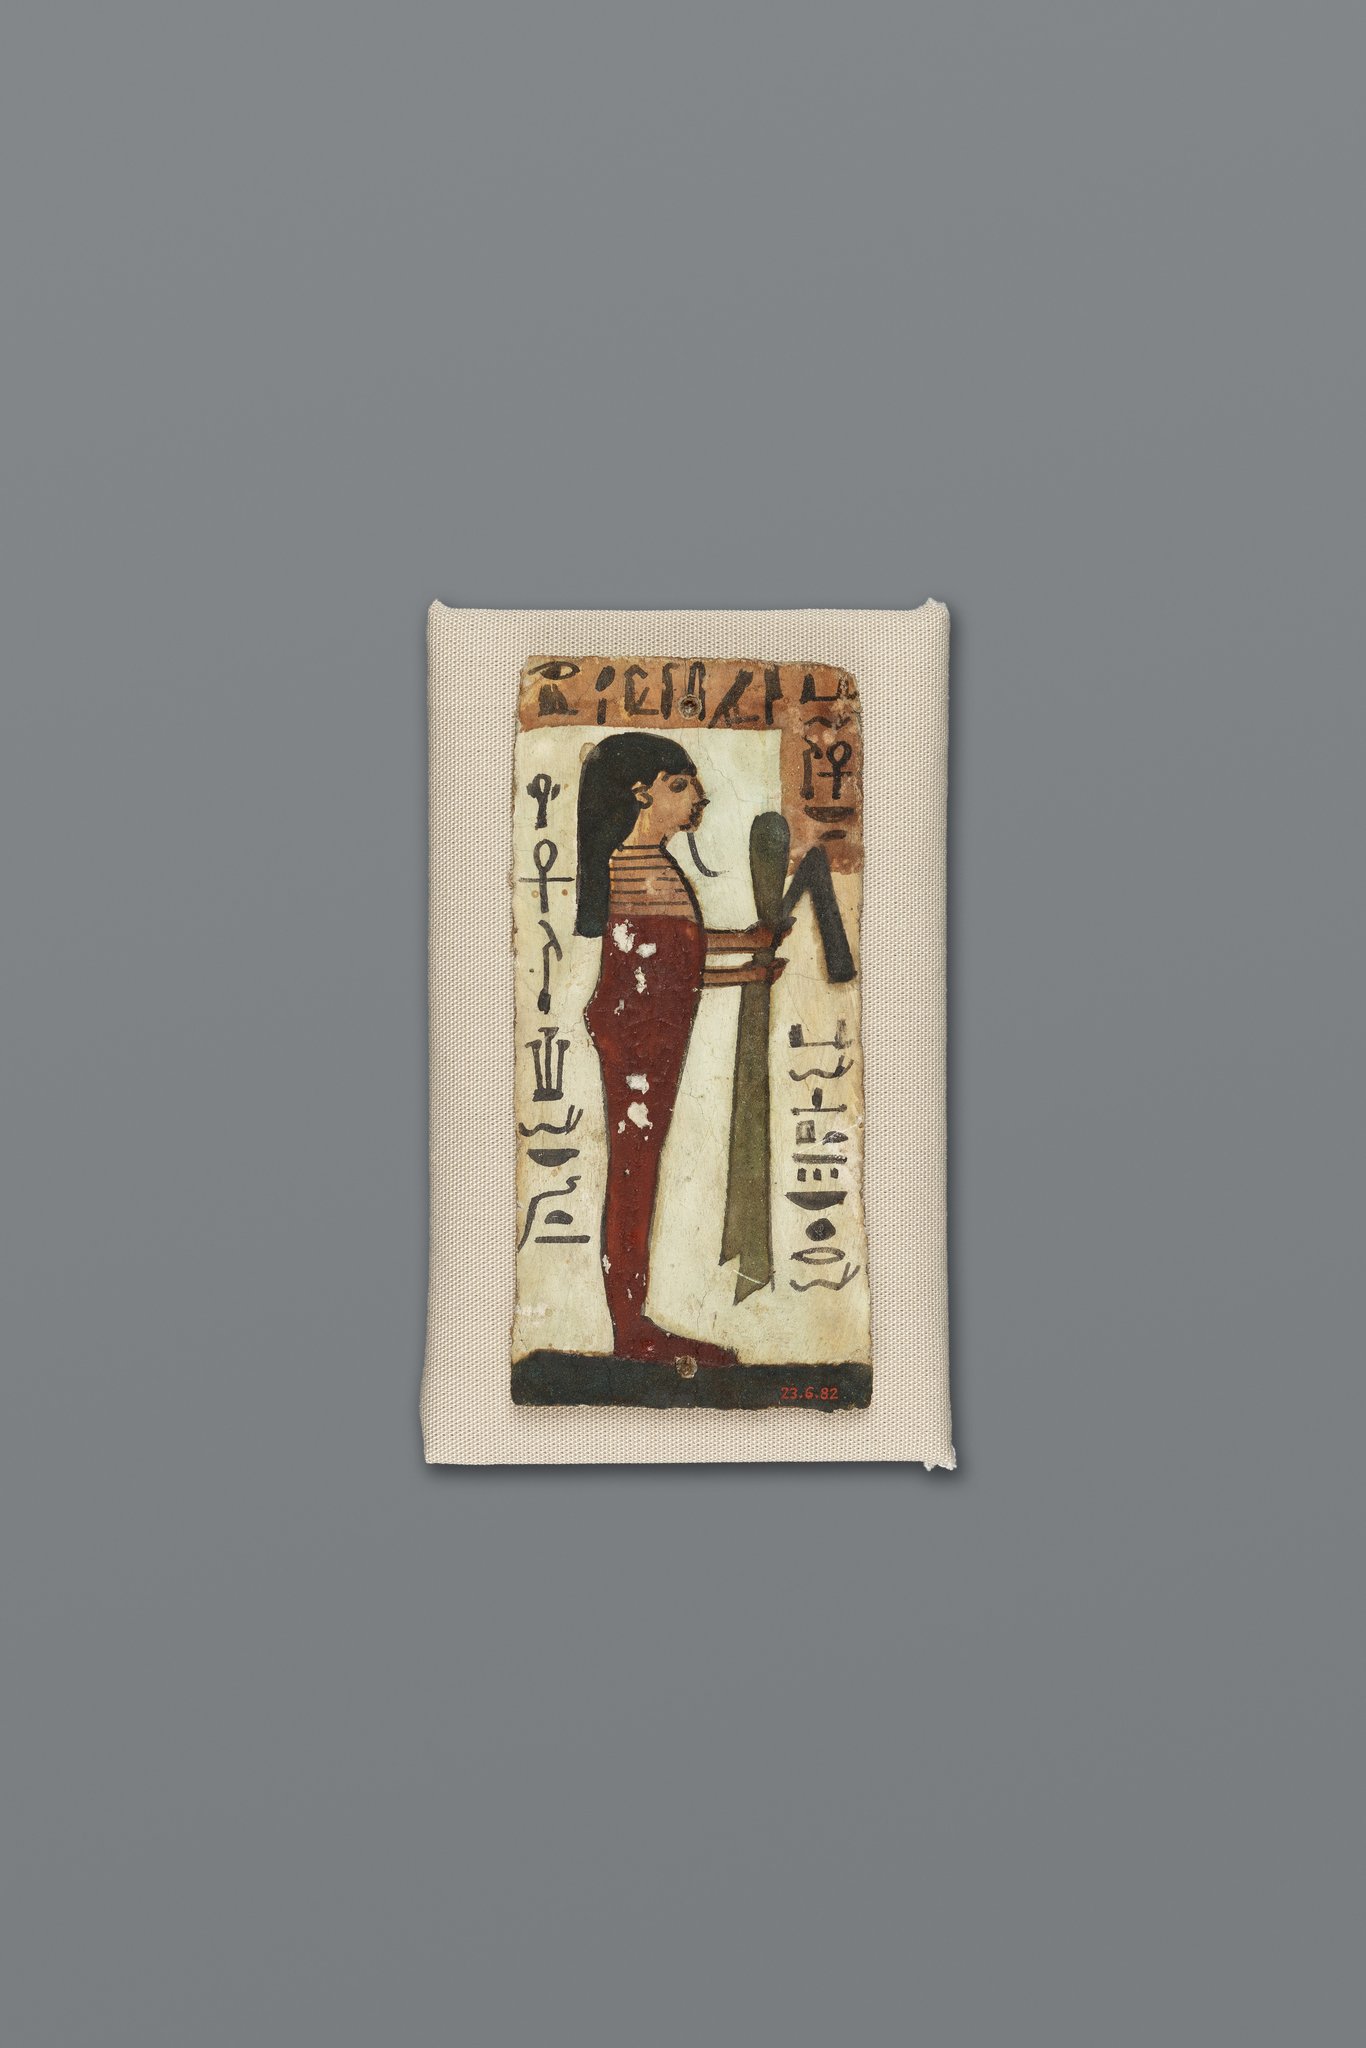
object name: cartonnage panel, imseti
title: Cartonnage panel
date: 712-332 BCE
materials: gesso, paint, wood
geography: egypt